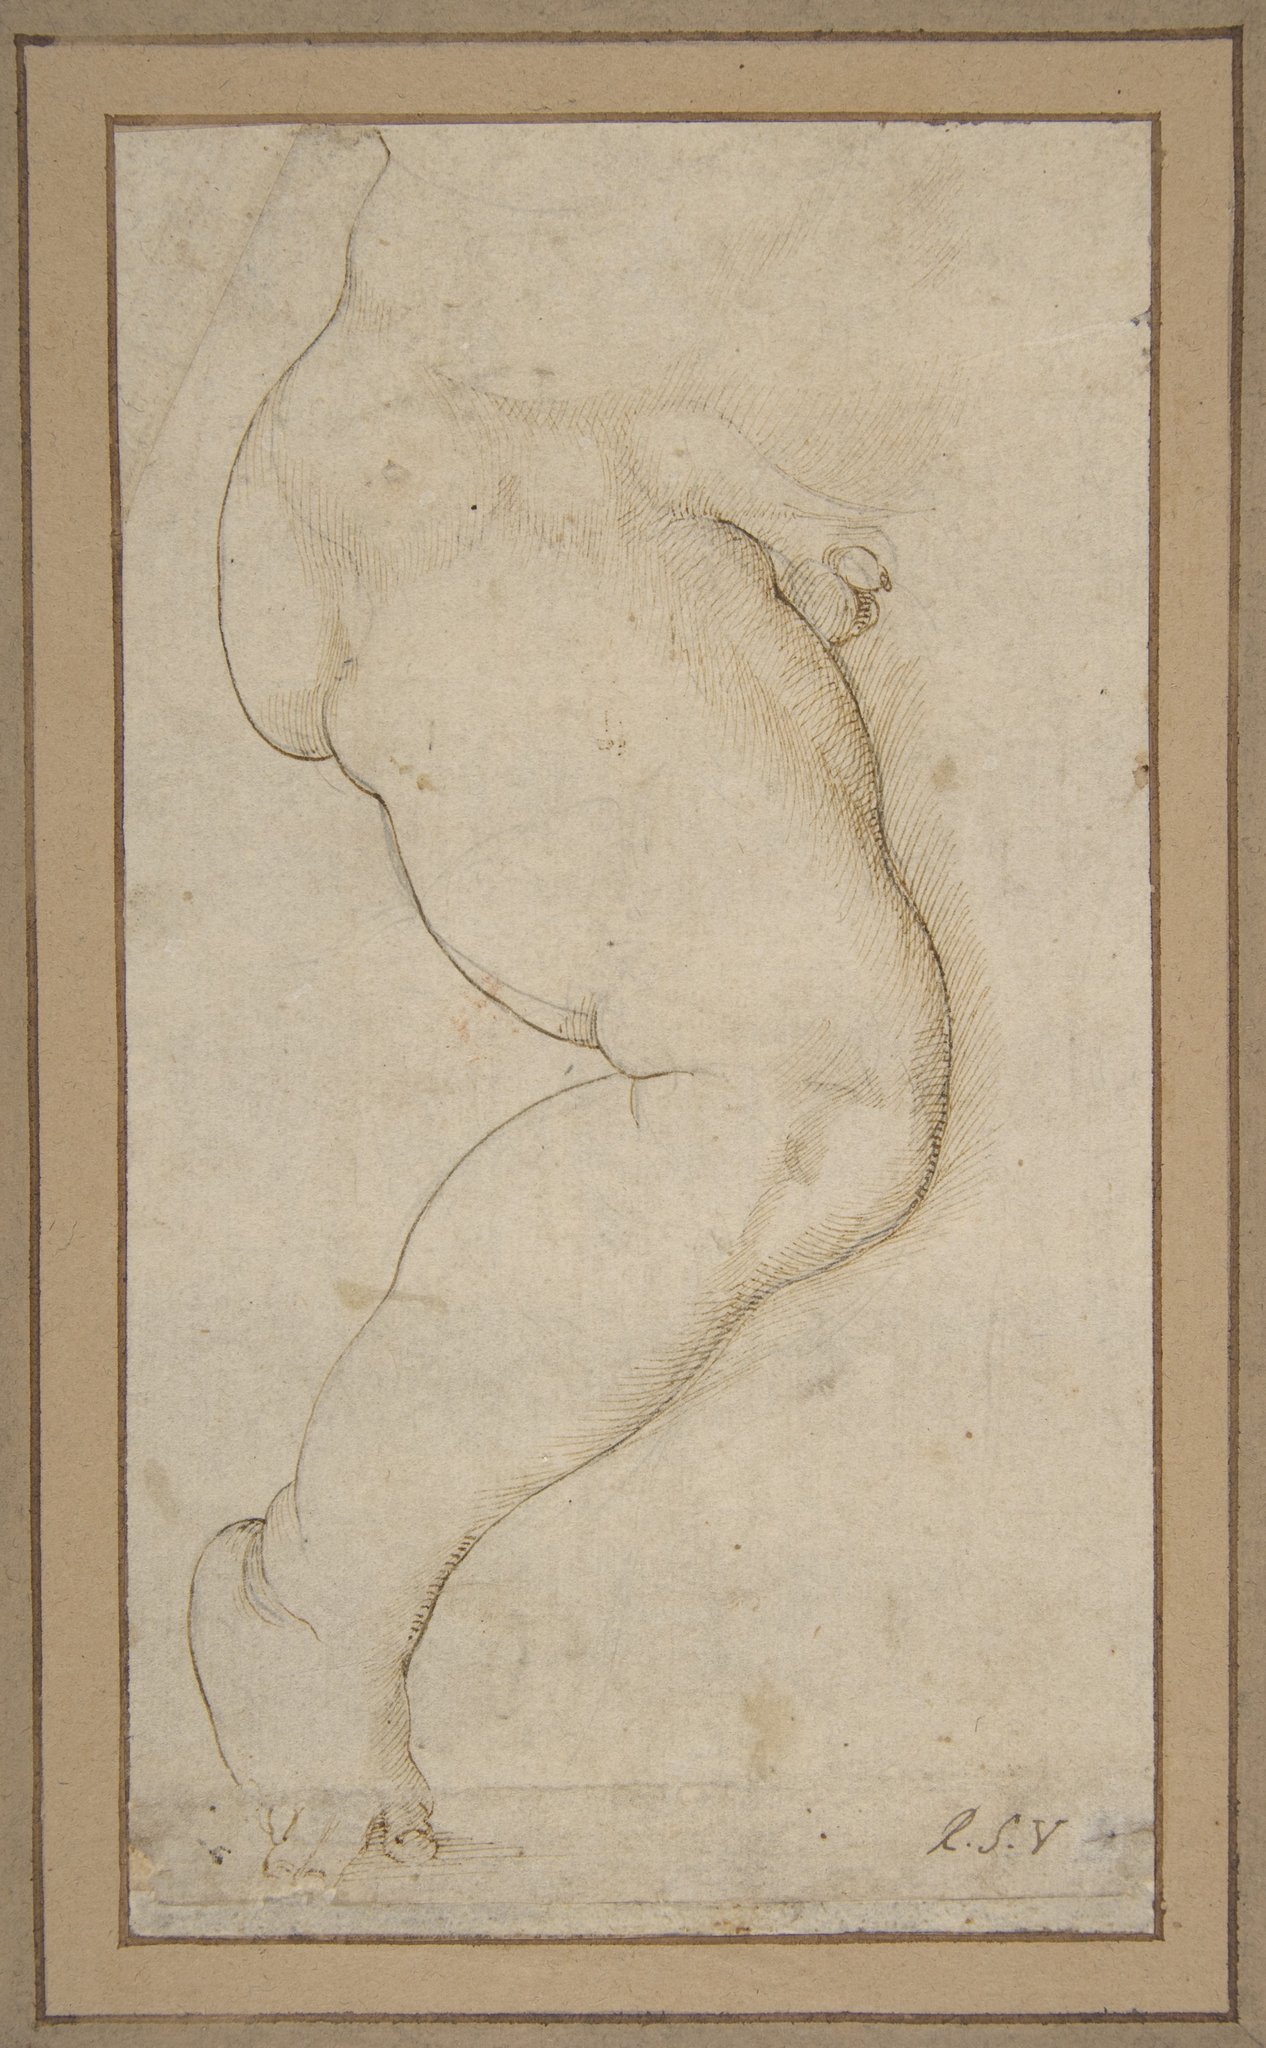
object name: drawing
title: Study of the Right Leg of a Male Child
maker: raphael (raffaello sanzio or santi)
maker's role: artist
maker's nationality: italian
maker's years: 1483-1520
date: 1483-1520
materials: chalk, ink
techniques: pen, drawing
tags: feet,boys